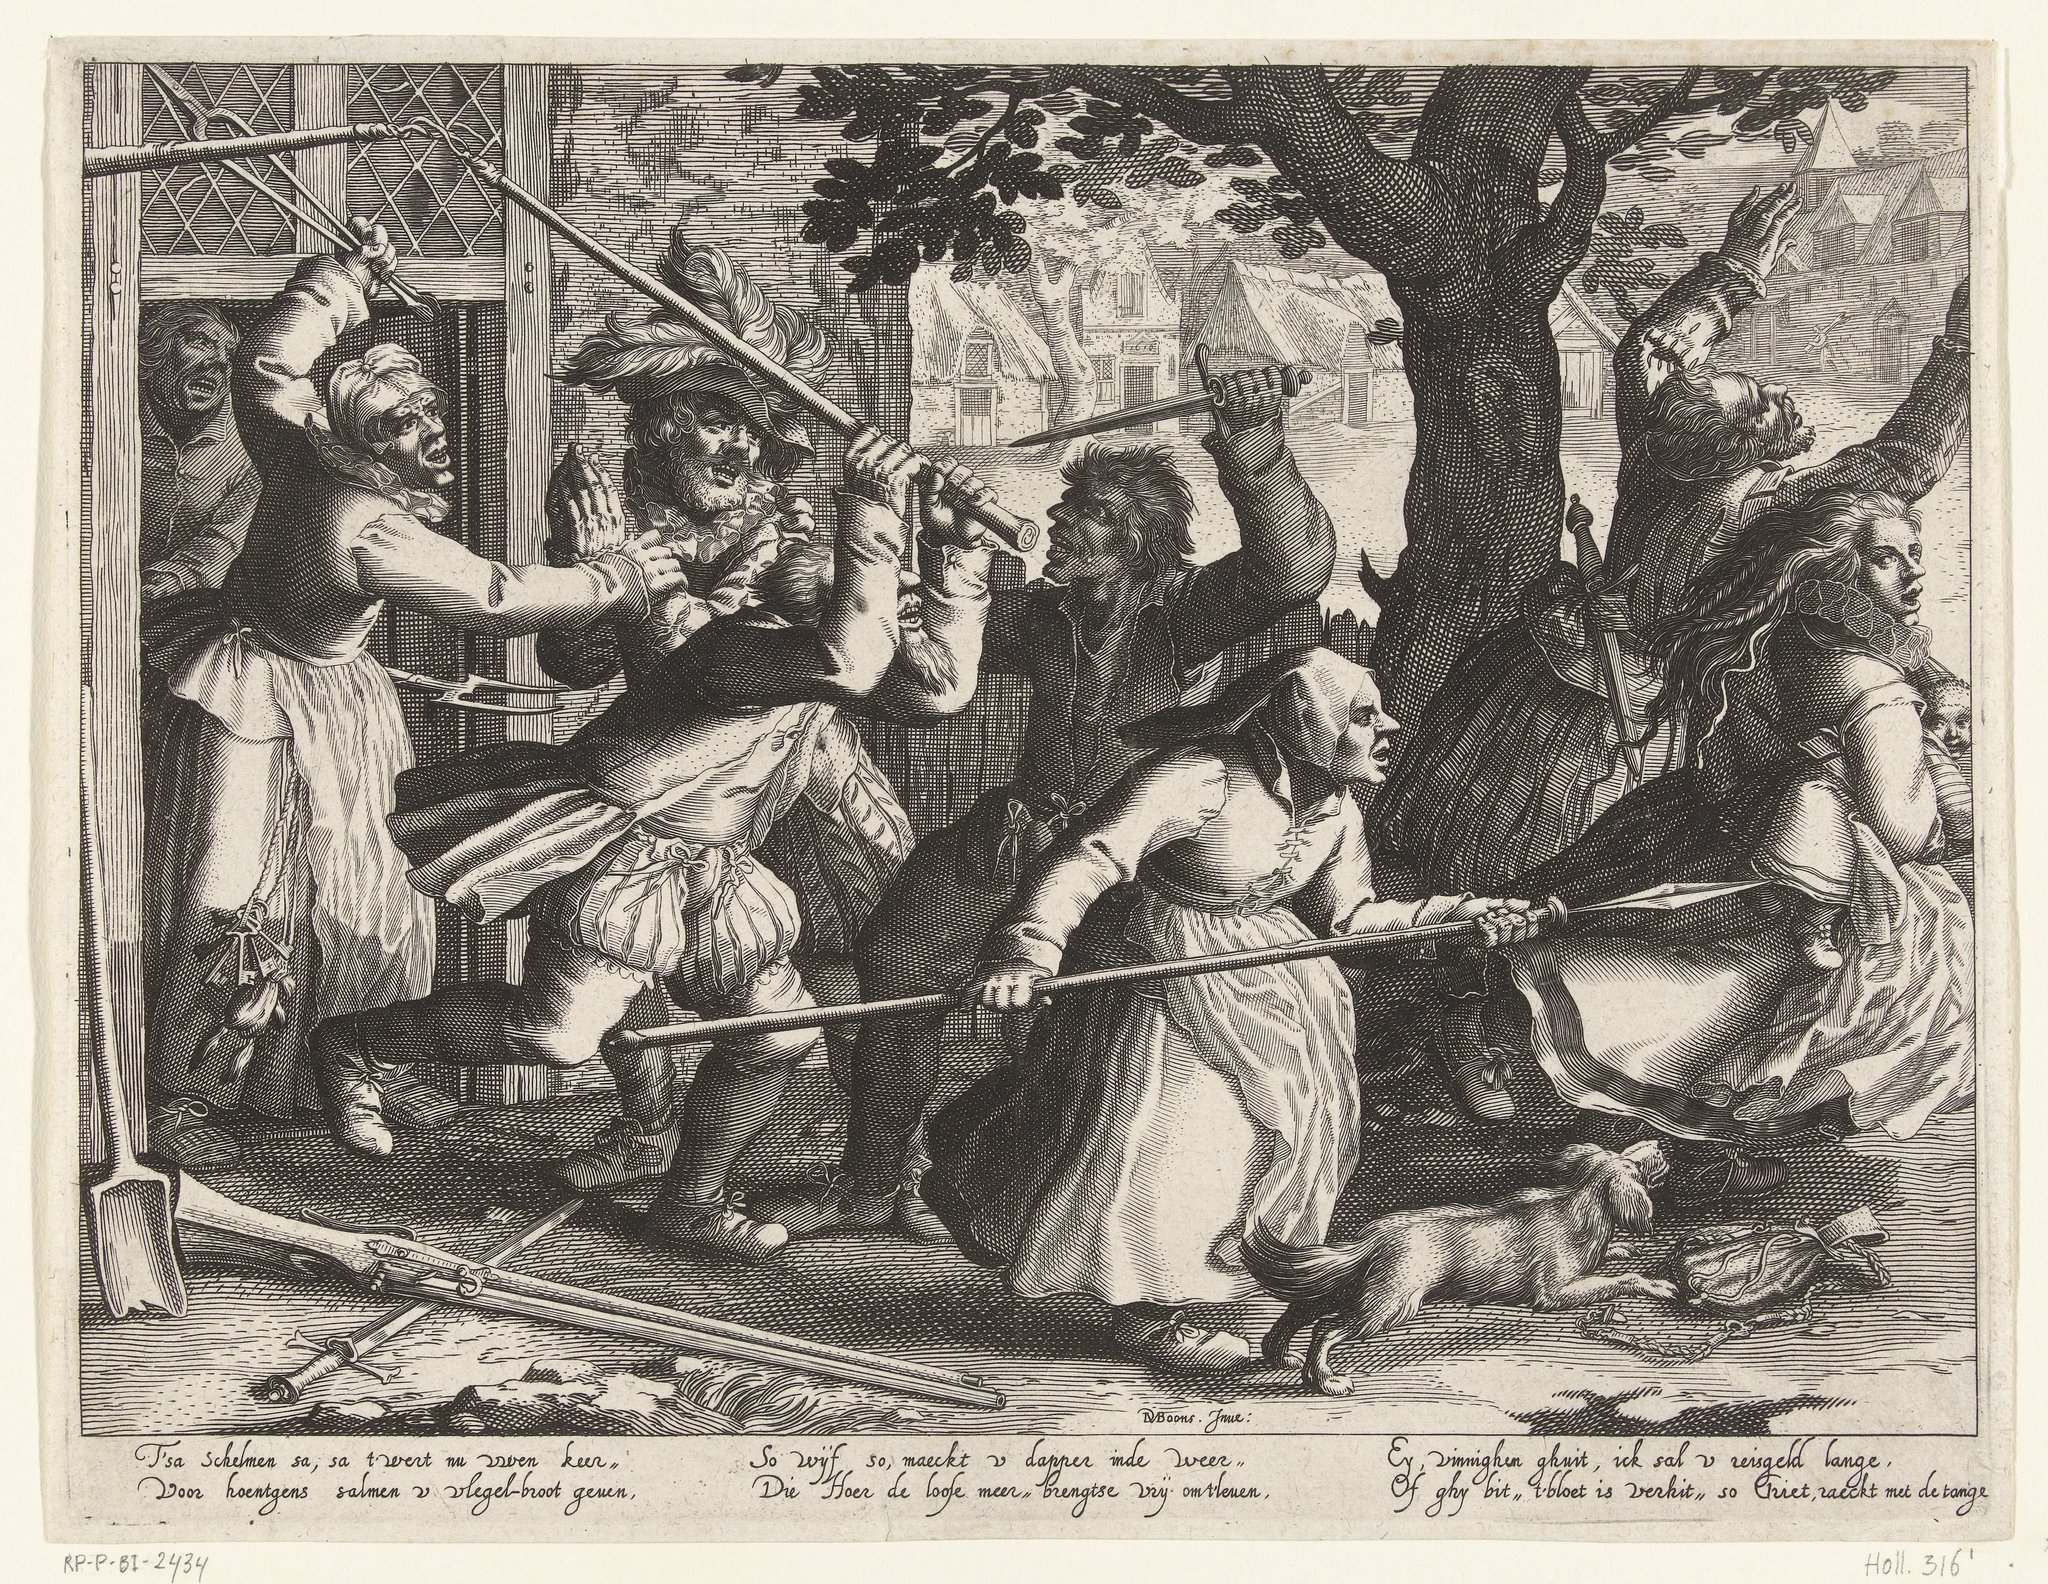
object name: print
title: Boerenverdriet: de kwellingen van de Spaanse Oorlog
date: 1610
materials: paper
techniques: engraving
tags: fight between farmers and soldiers, contrast between rich and poor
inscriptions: inscription: ‘T'sa schelmen sa, sa t wert nu uwen keer...Of ghy bit, "t bloet is verhit" so Triet, raeckt met de tange’, collector's mark: Lugt 240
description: Boeren in gevecht met rijken. De rijke mensen worden door de boeren met dorsvlegels en ander wapentuig uit hun huis verdreven. Onder de voorstelling staat een spottend vers dat zegt nu is het de beurt aan de rijken.